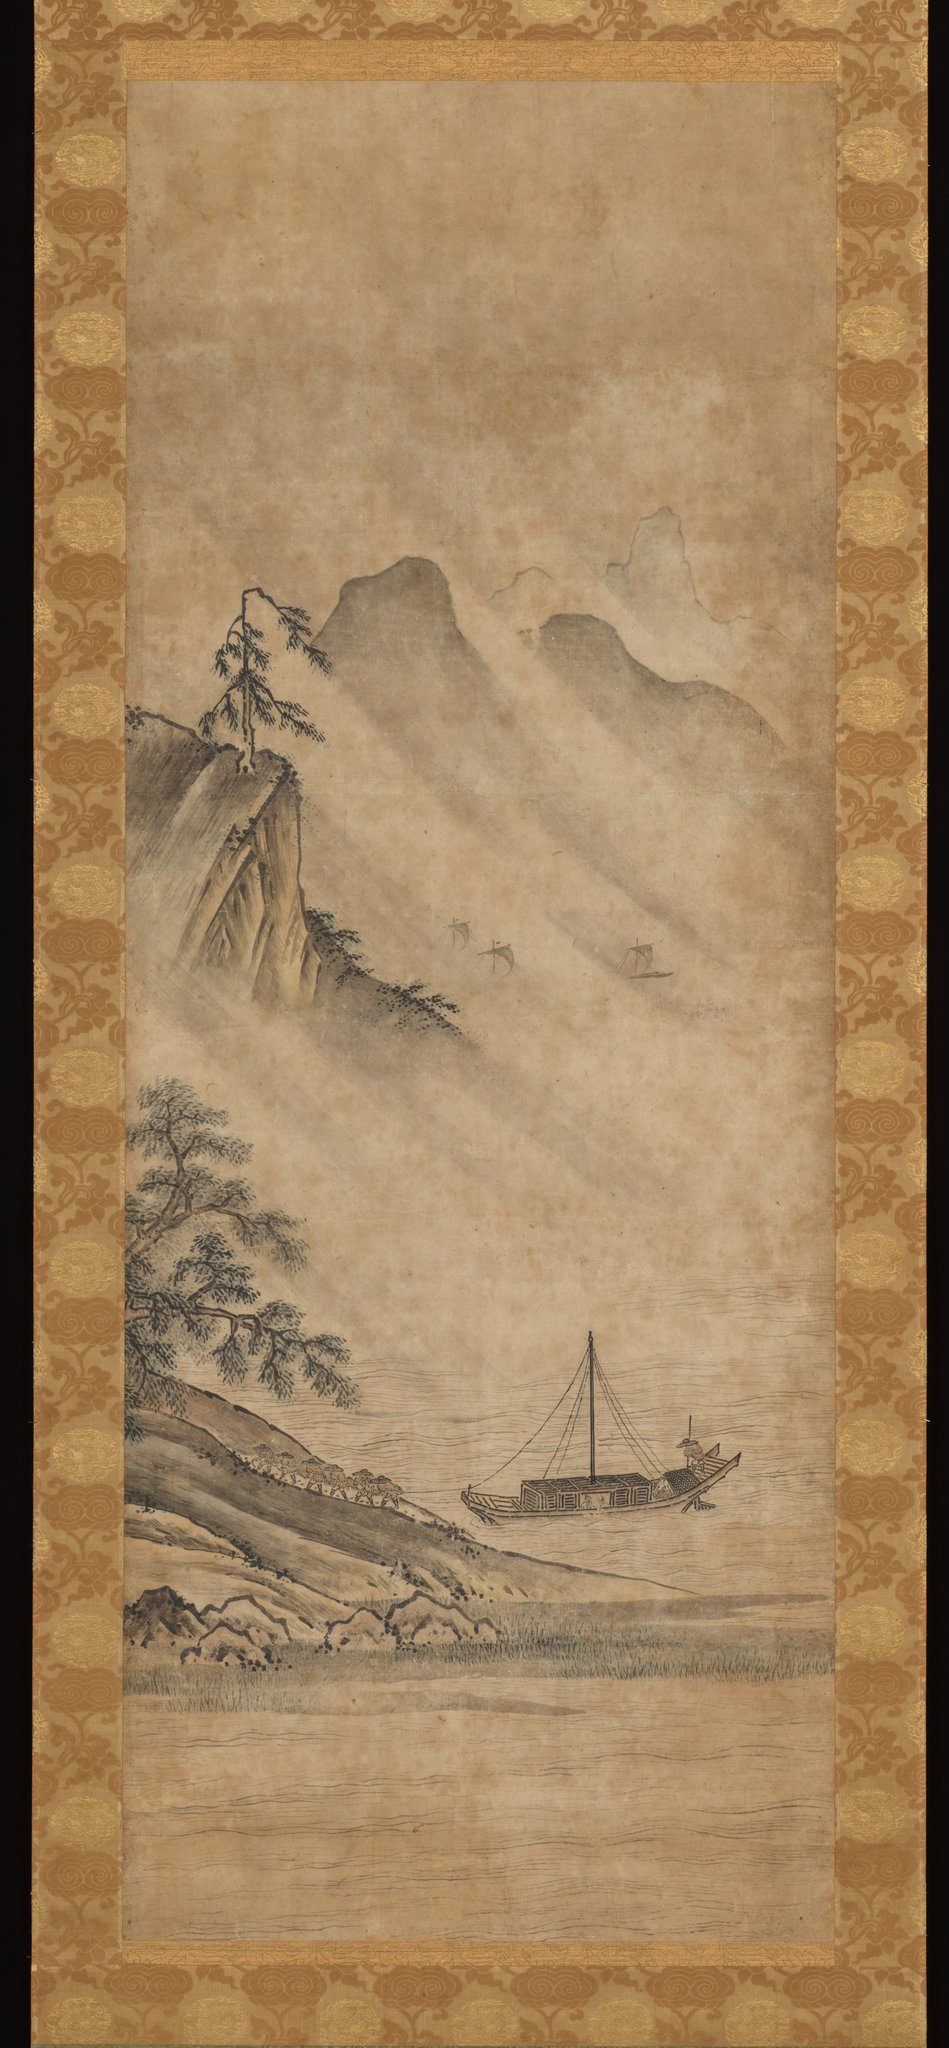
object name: hanging scroll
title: Eight Views of the Xiao and Xiang Rivers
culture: japanese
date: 1501-1600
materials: ink, paper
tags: mountains,landscapes,boats